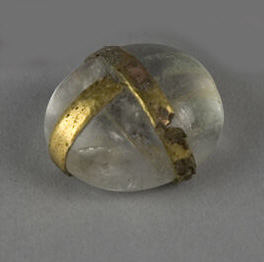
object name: relic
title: Rock Crystal Relic in Spherical Shape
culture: cambodian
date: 1101-1200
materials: quartz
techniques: gilding